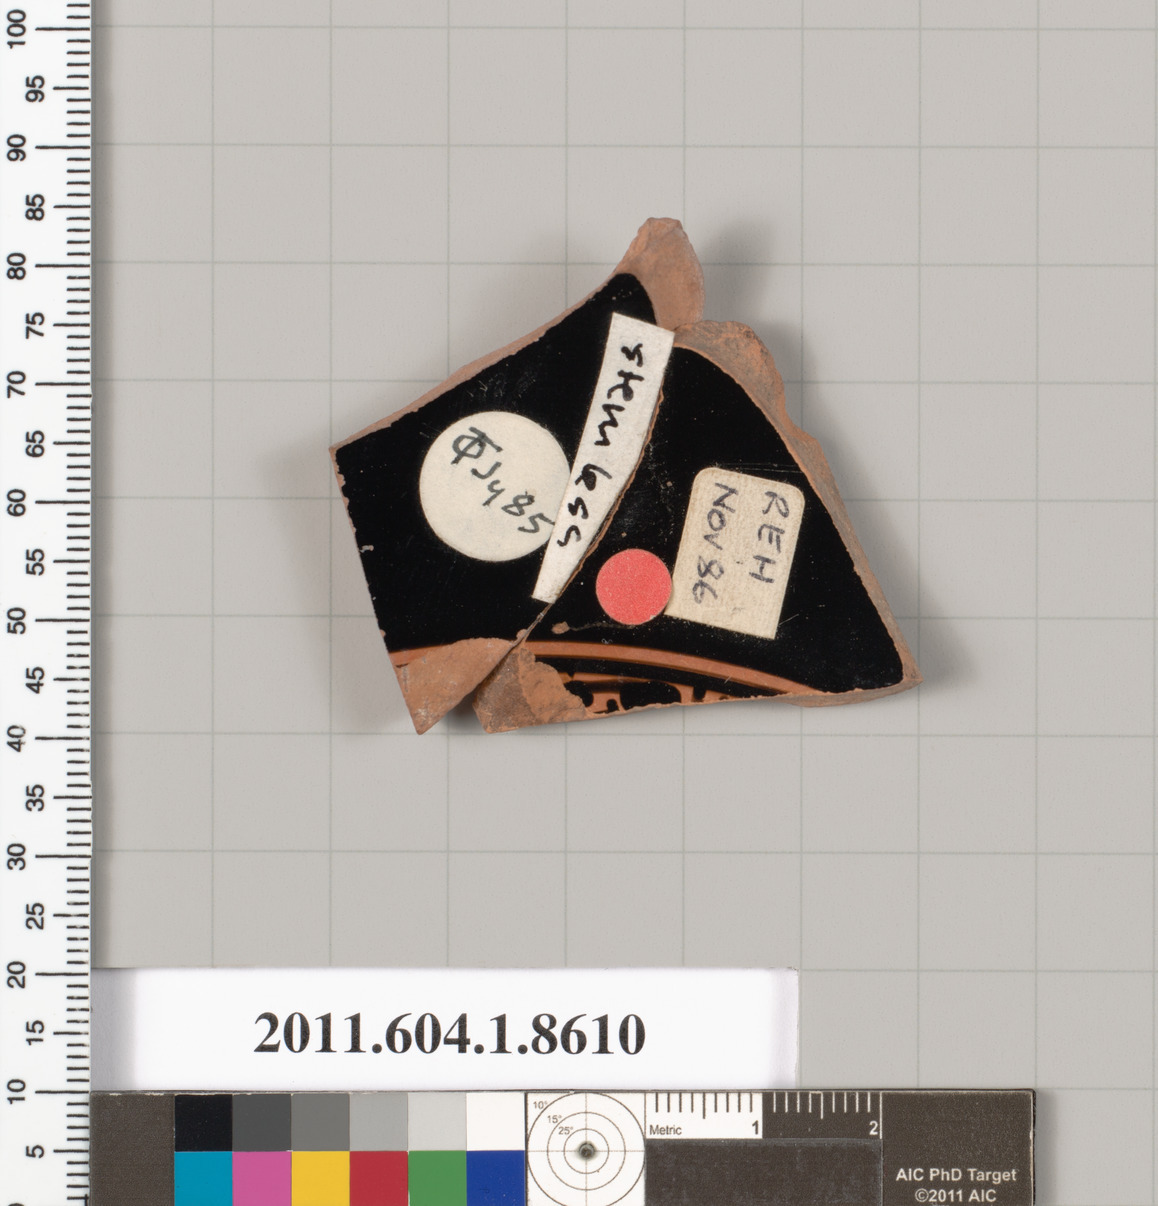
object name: kylix fragment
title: Terracotta fragment of a stemless kylix (drinking cup)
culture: greek, attic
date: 460-450 BCE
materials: terracotta